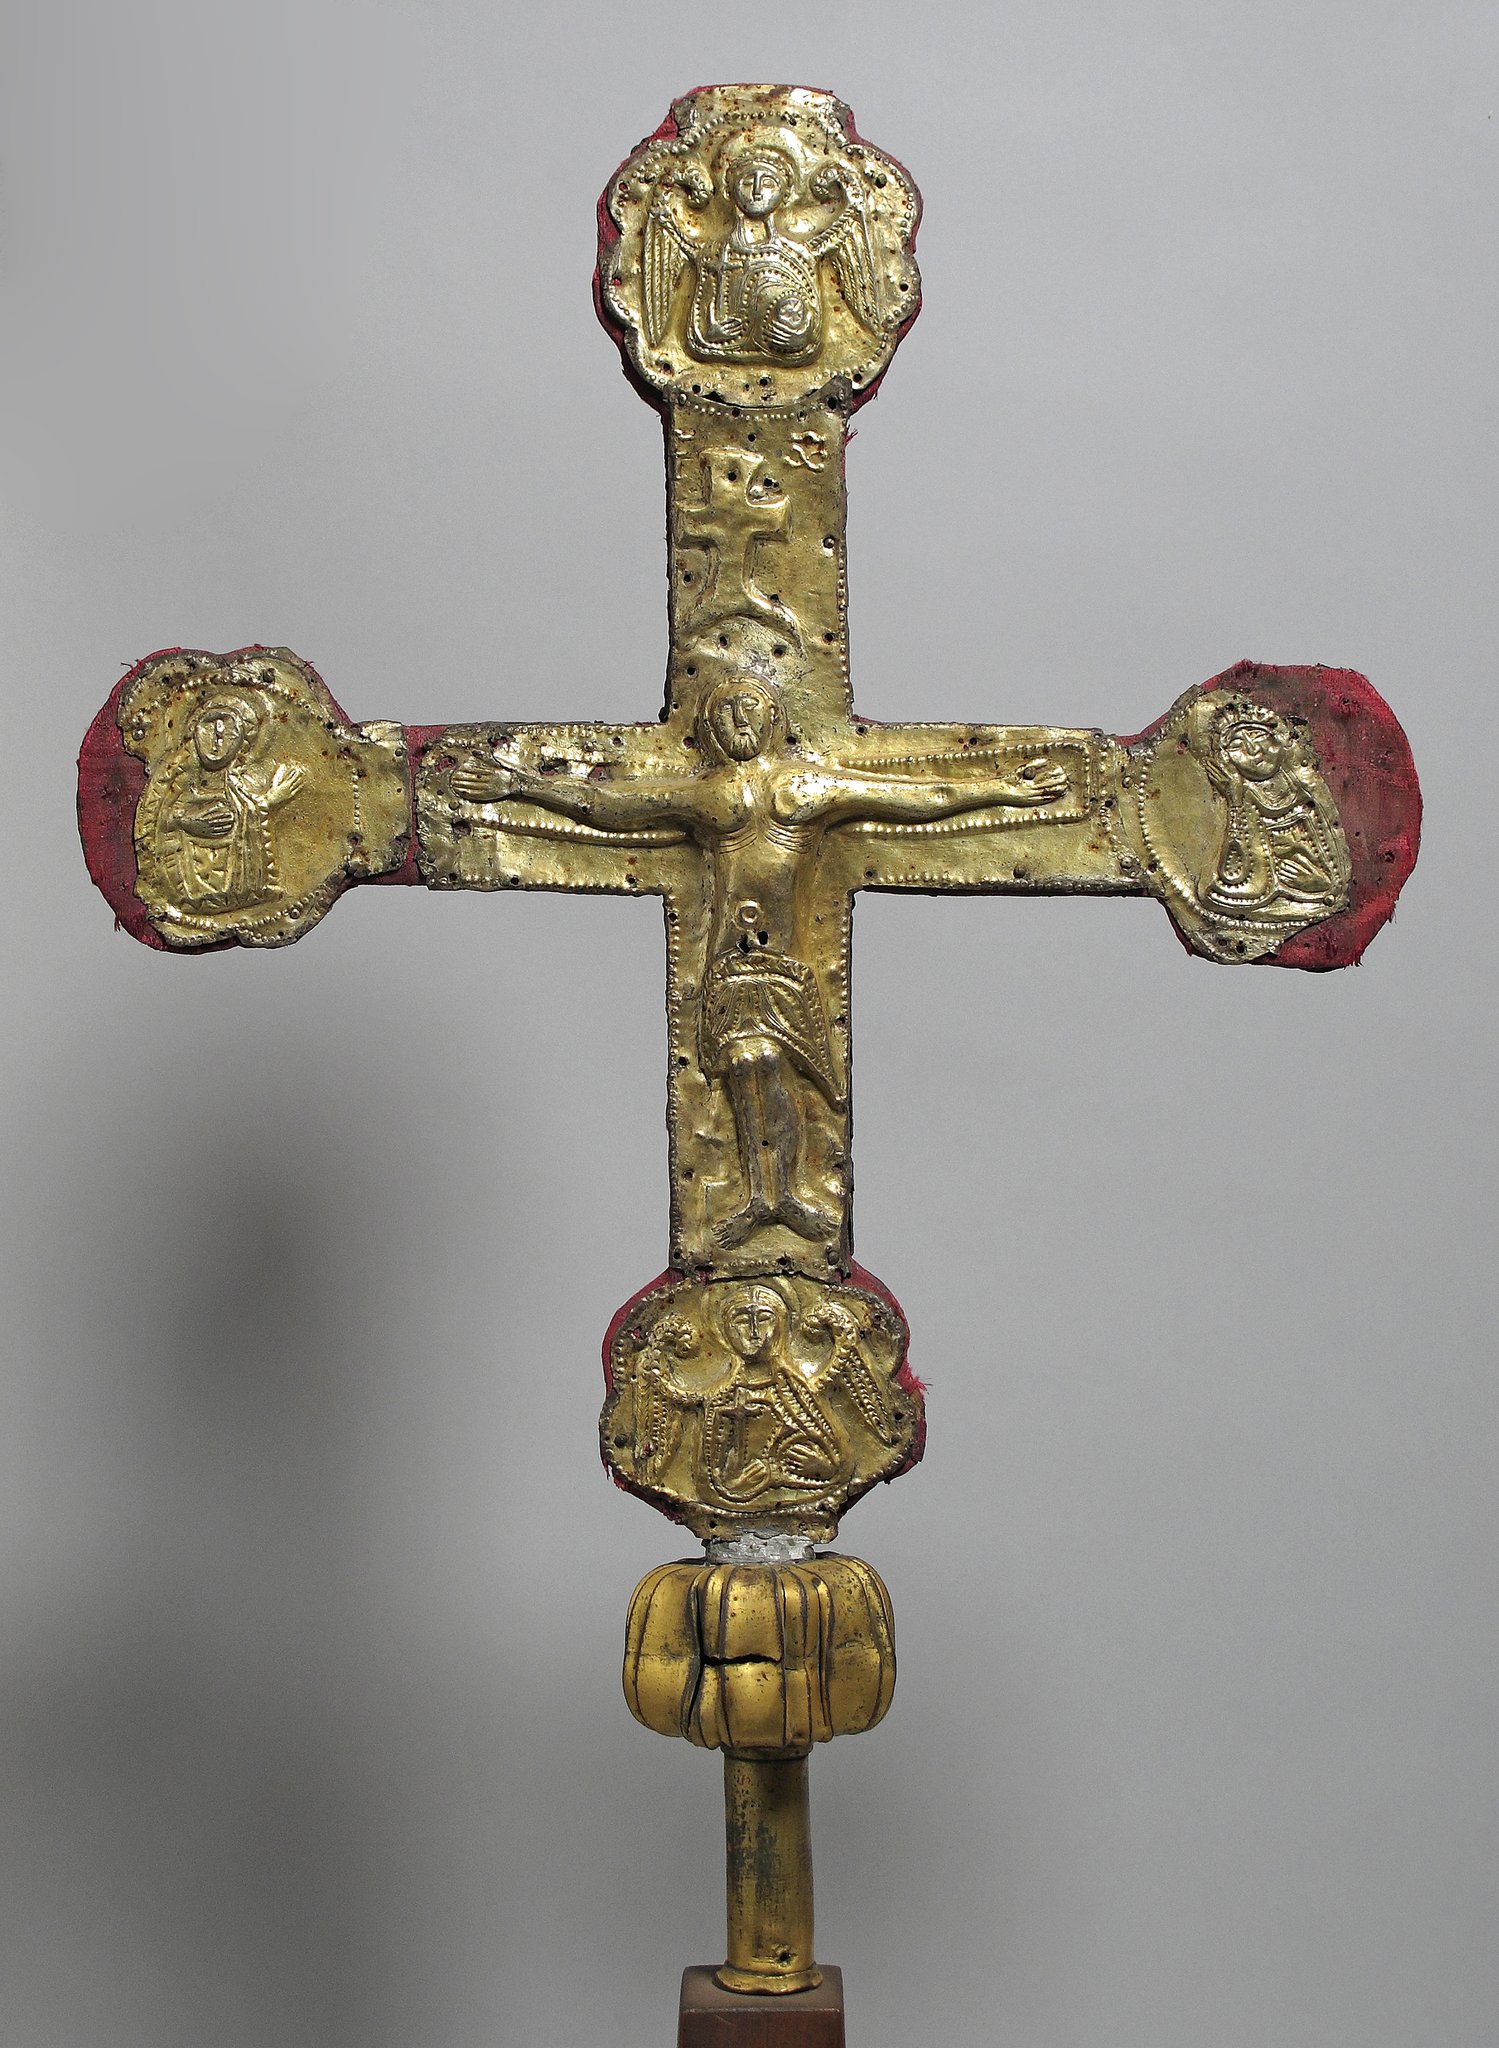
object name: cross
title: Processional Cross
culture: spanish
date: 1001-1100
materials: silver gilt, wood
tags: angels,christ,crucifixion